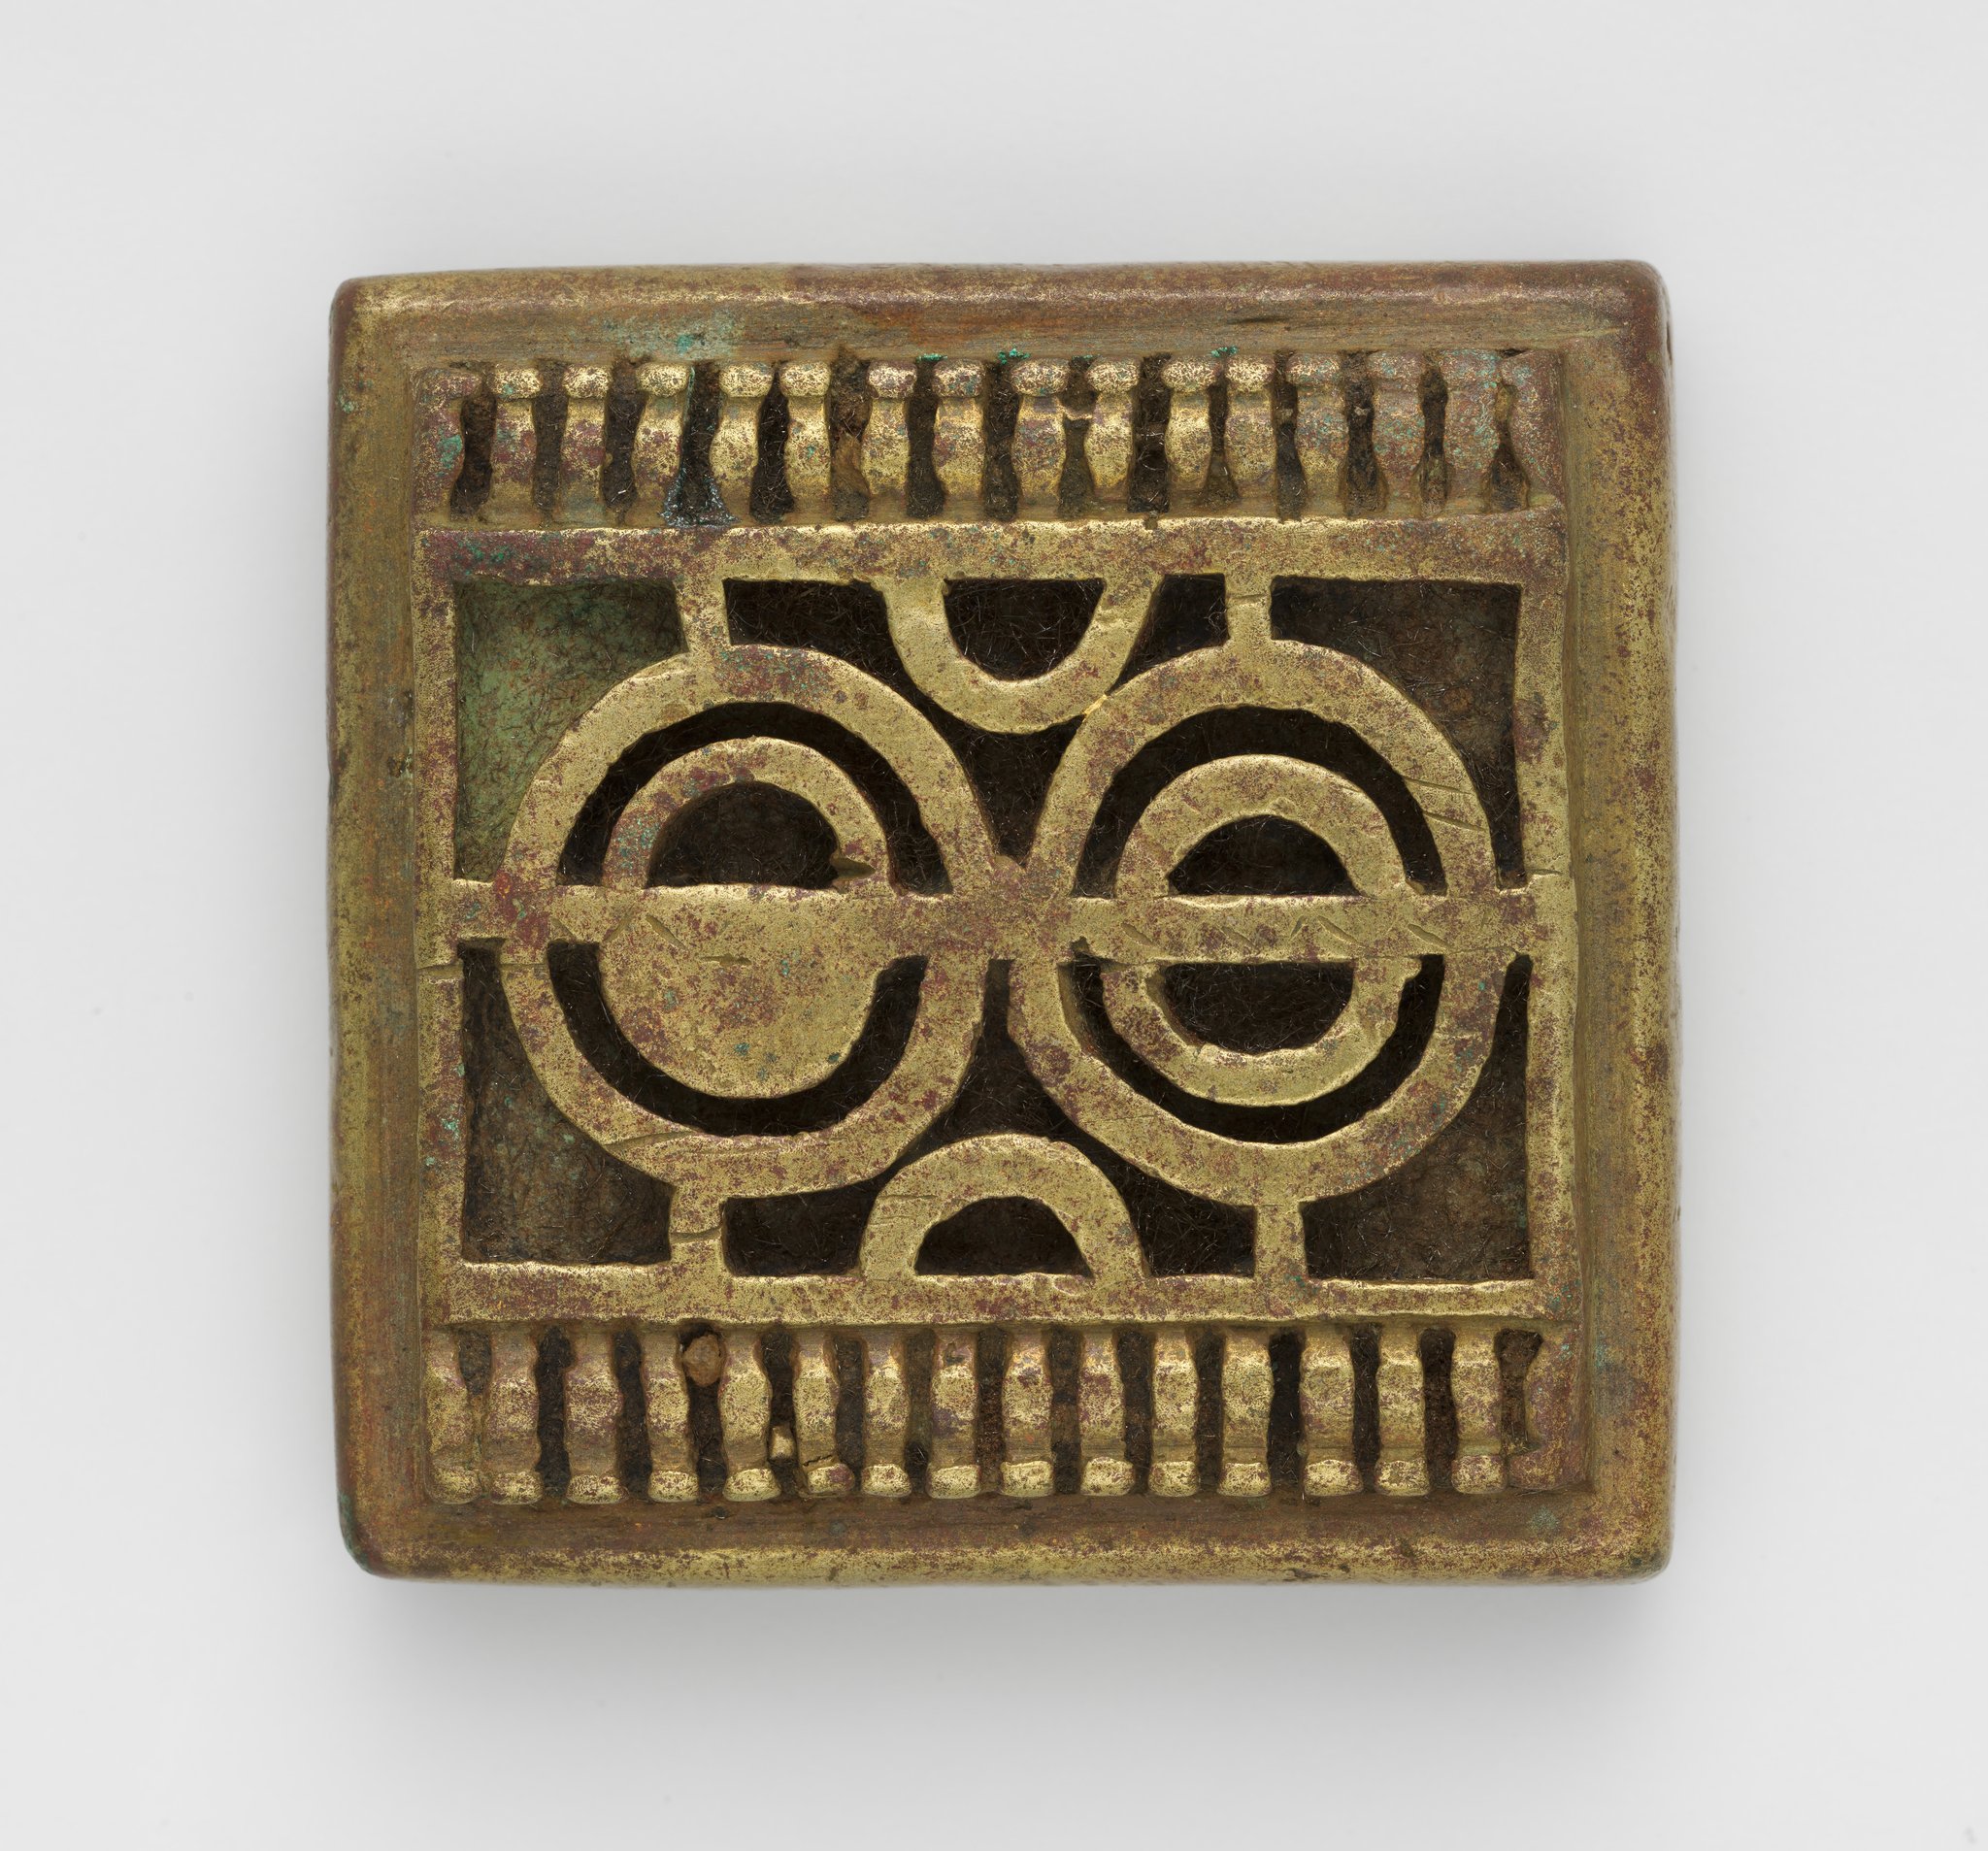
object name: weight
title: Geometric gold weight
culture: akan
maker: akan artist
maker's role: artist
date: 1701-1900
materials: brass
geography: côte d’ivoire